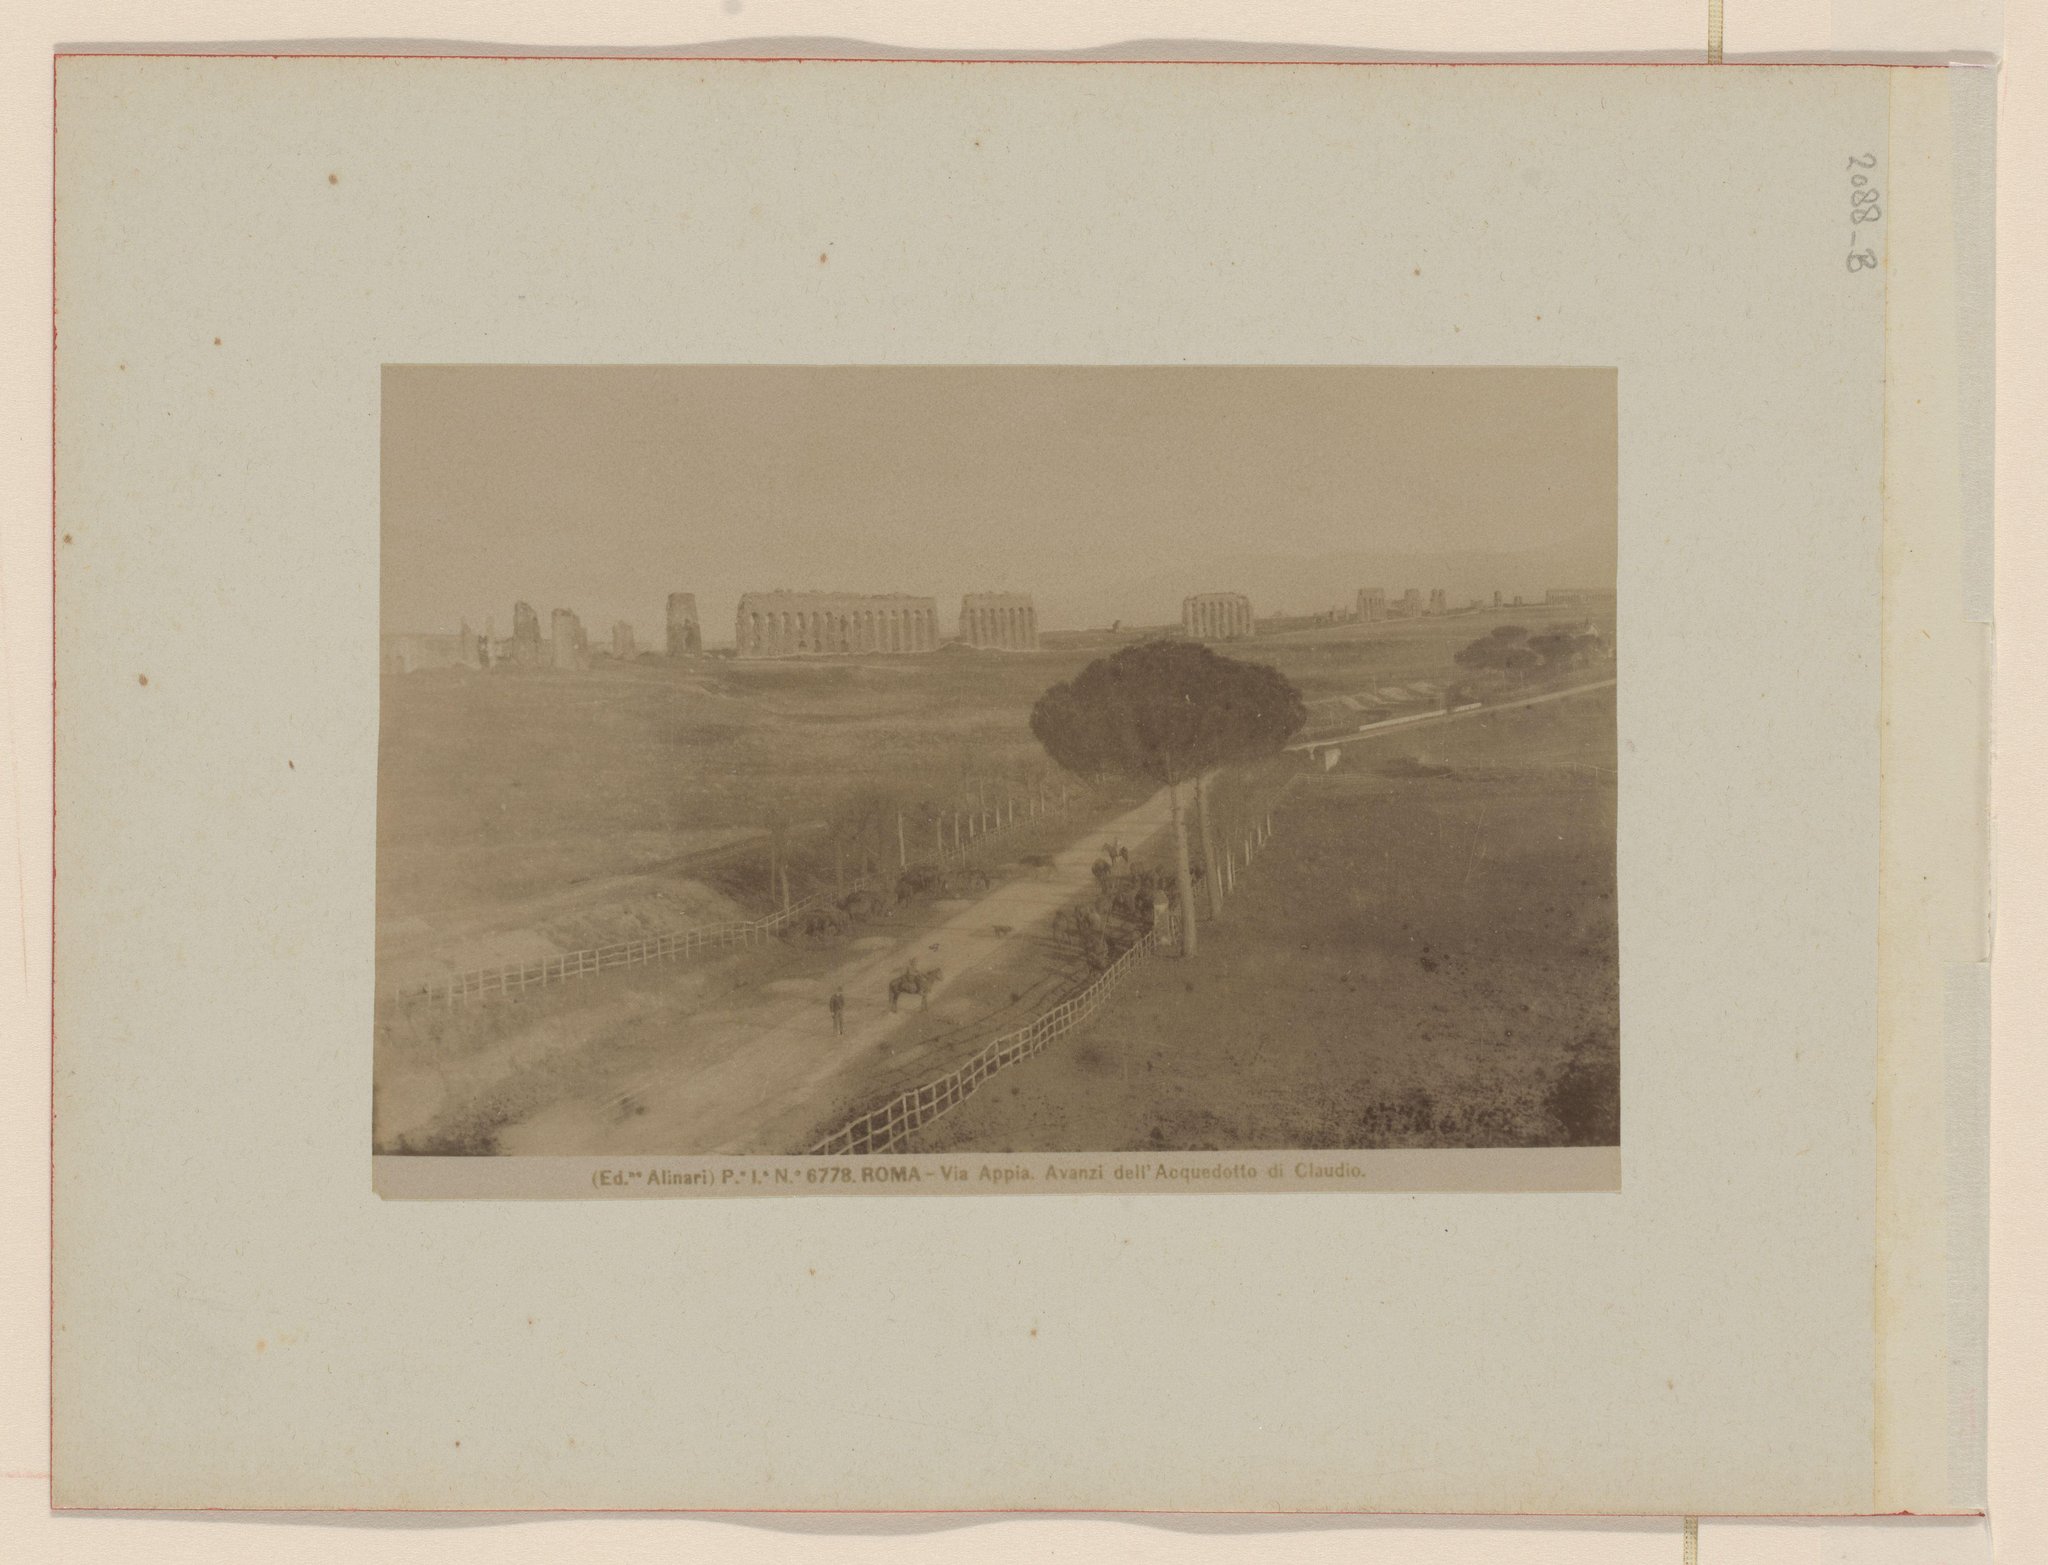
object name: photograph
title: Roma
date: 1857-1900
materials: cardboard, paper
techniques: albumen print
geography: rome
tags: public road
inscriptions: number: ‘Po. 1a. No. 6778.’